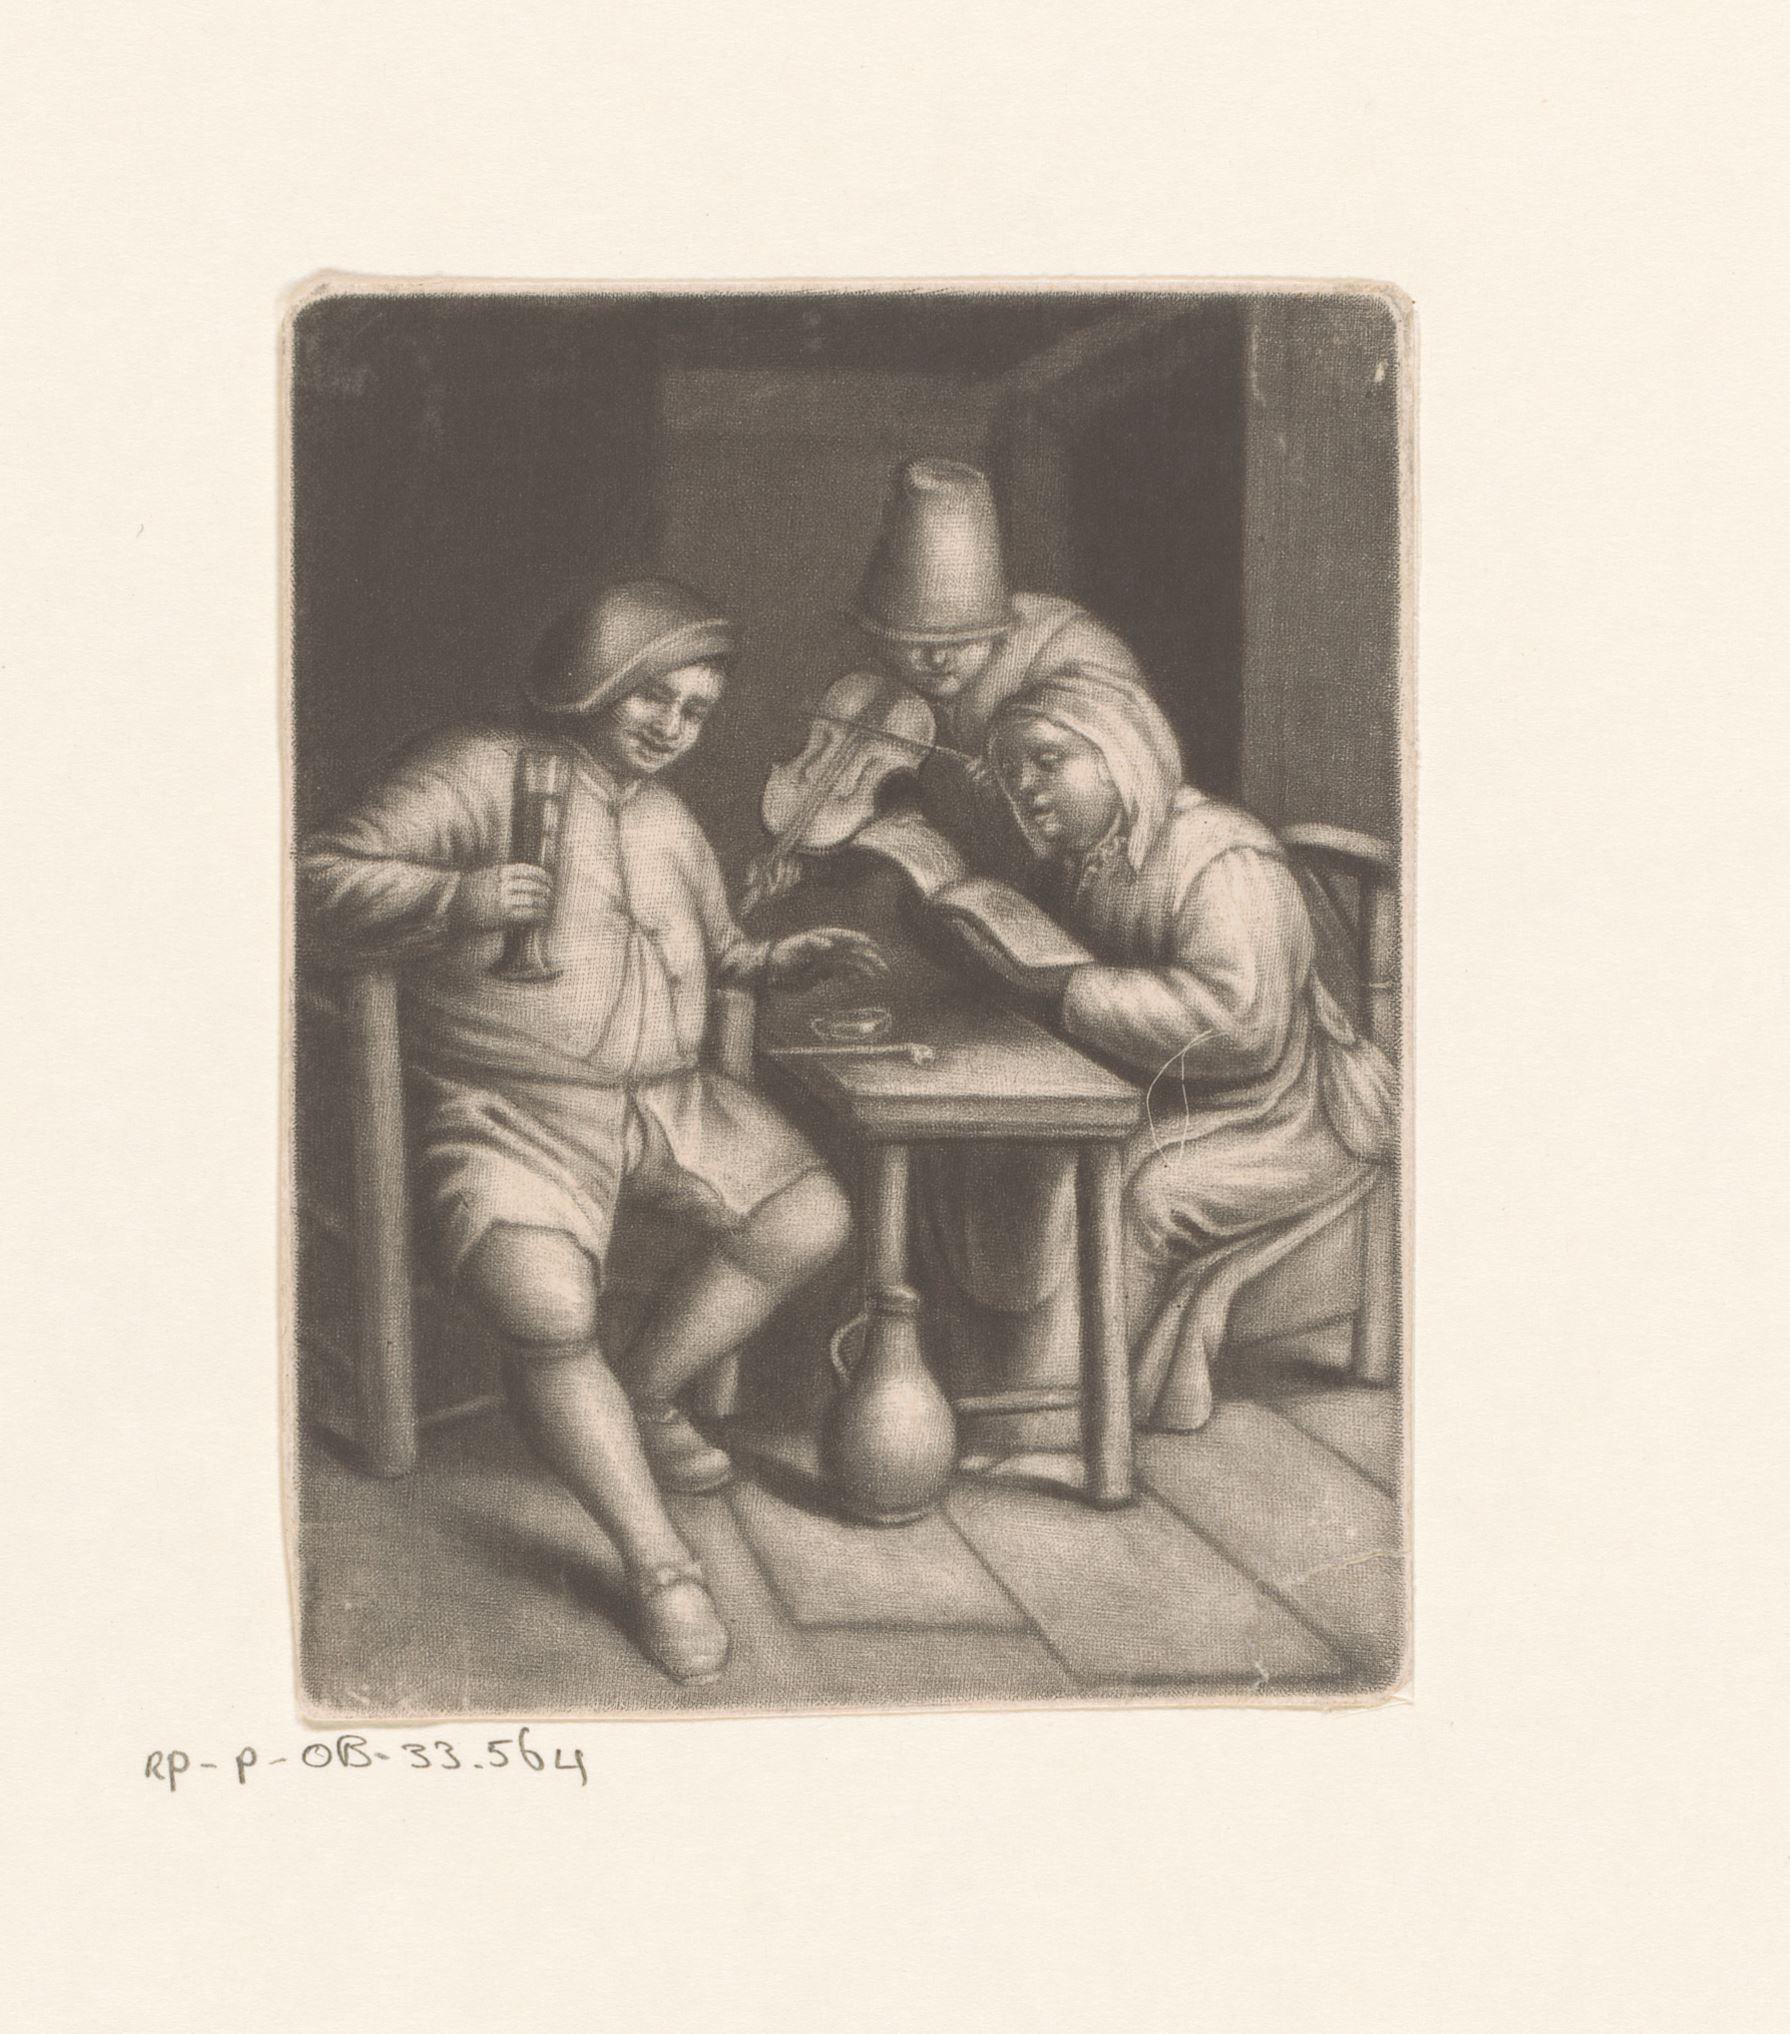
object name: print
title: Drinkende man, vioolspeler en zingende vrouw aan een tafel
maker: john smith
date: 1670-1700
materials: paper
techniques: mezzotint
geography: london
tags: festivities (+ solitary drinking ~ festive activities), one person playing string instrument (bowed), violin, fiddle, vocal music, singing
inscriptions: collector's mark: Lugt 240